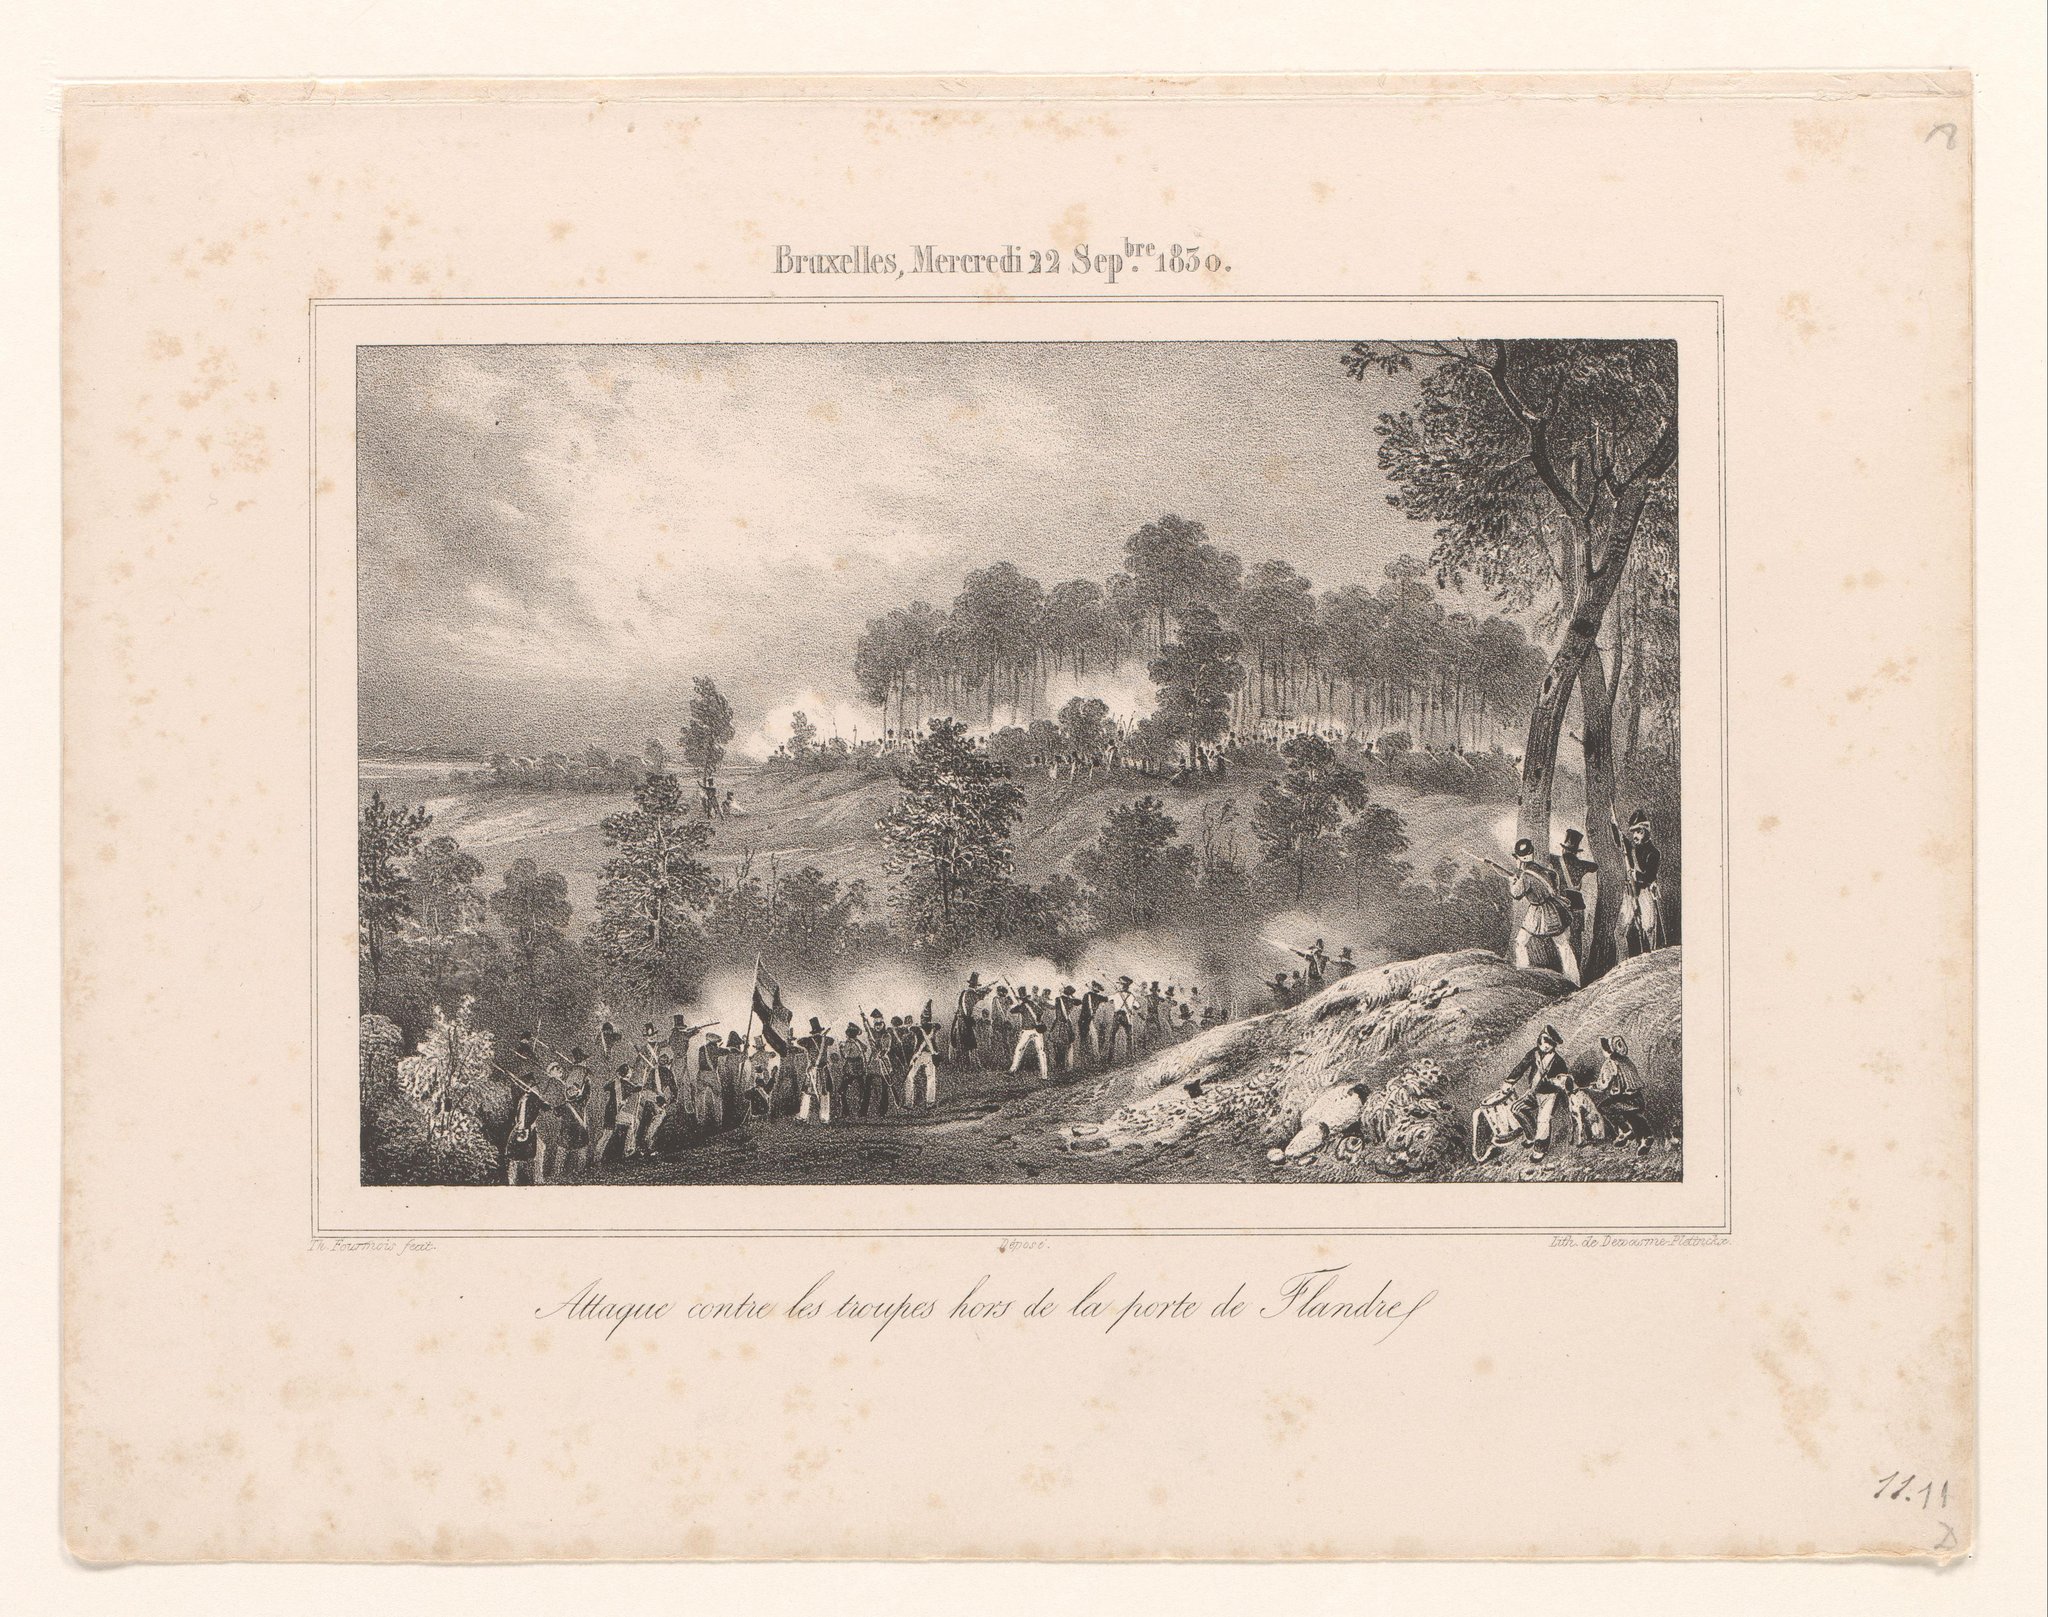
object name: print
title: Evénemens de Bruxelles, Anvers (...) (1831)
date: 1830-1831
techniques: lithograph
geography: brussels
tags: battle (+ land forces), brussels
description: Onderdeel van een recueil met platen over de gebeurtenissen tijdens de Belgische Revolutie in Brussel, Antwerpen en andere steden in de periode 25 augustus 1830 tot 27 maart 1831.